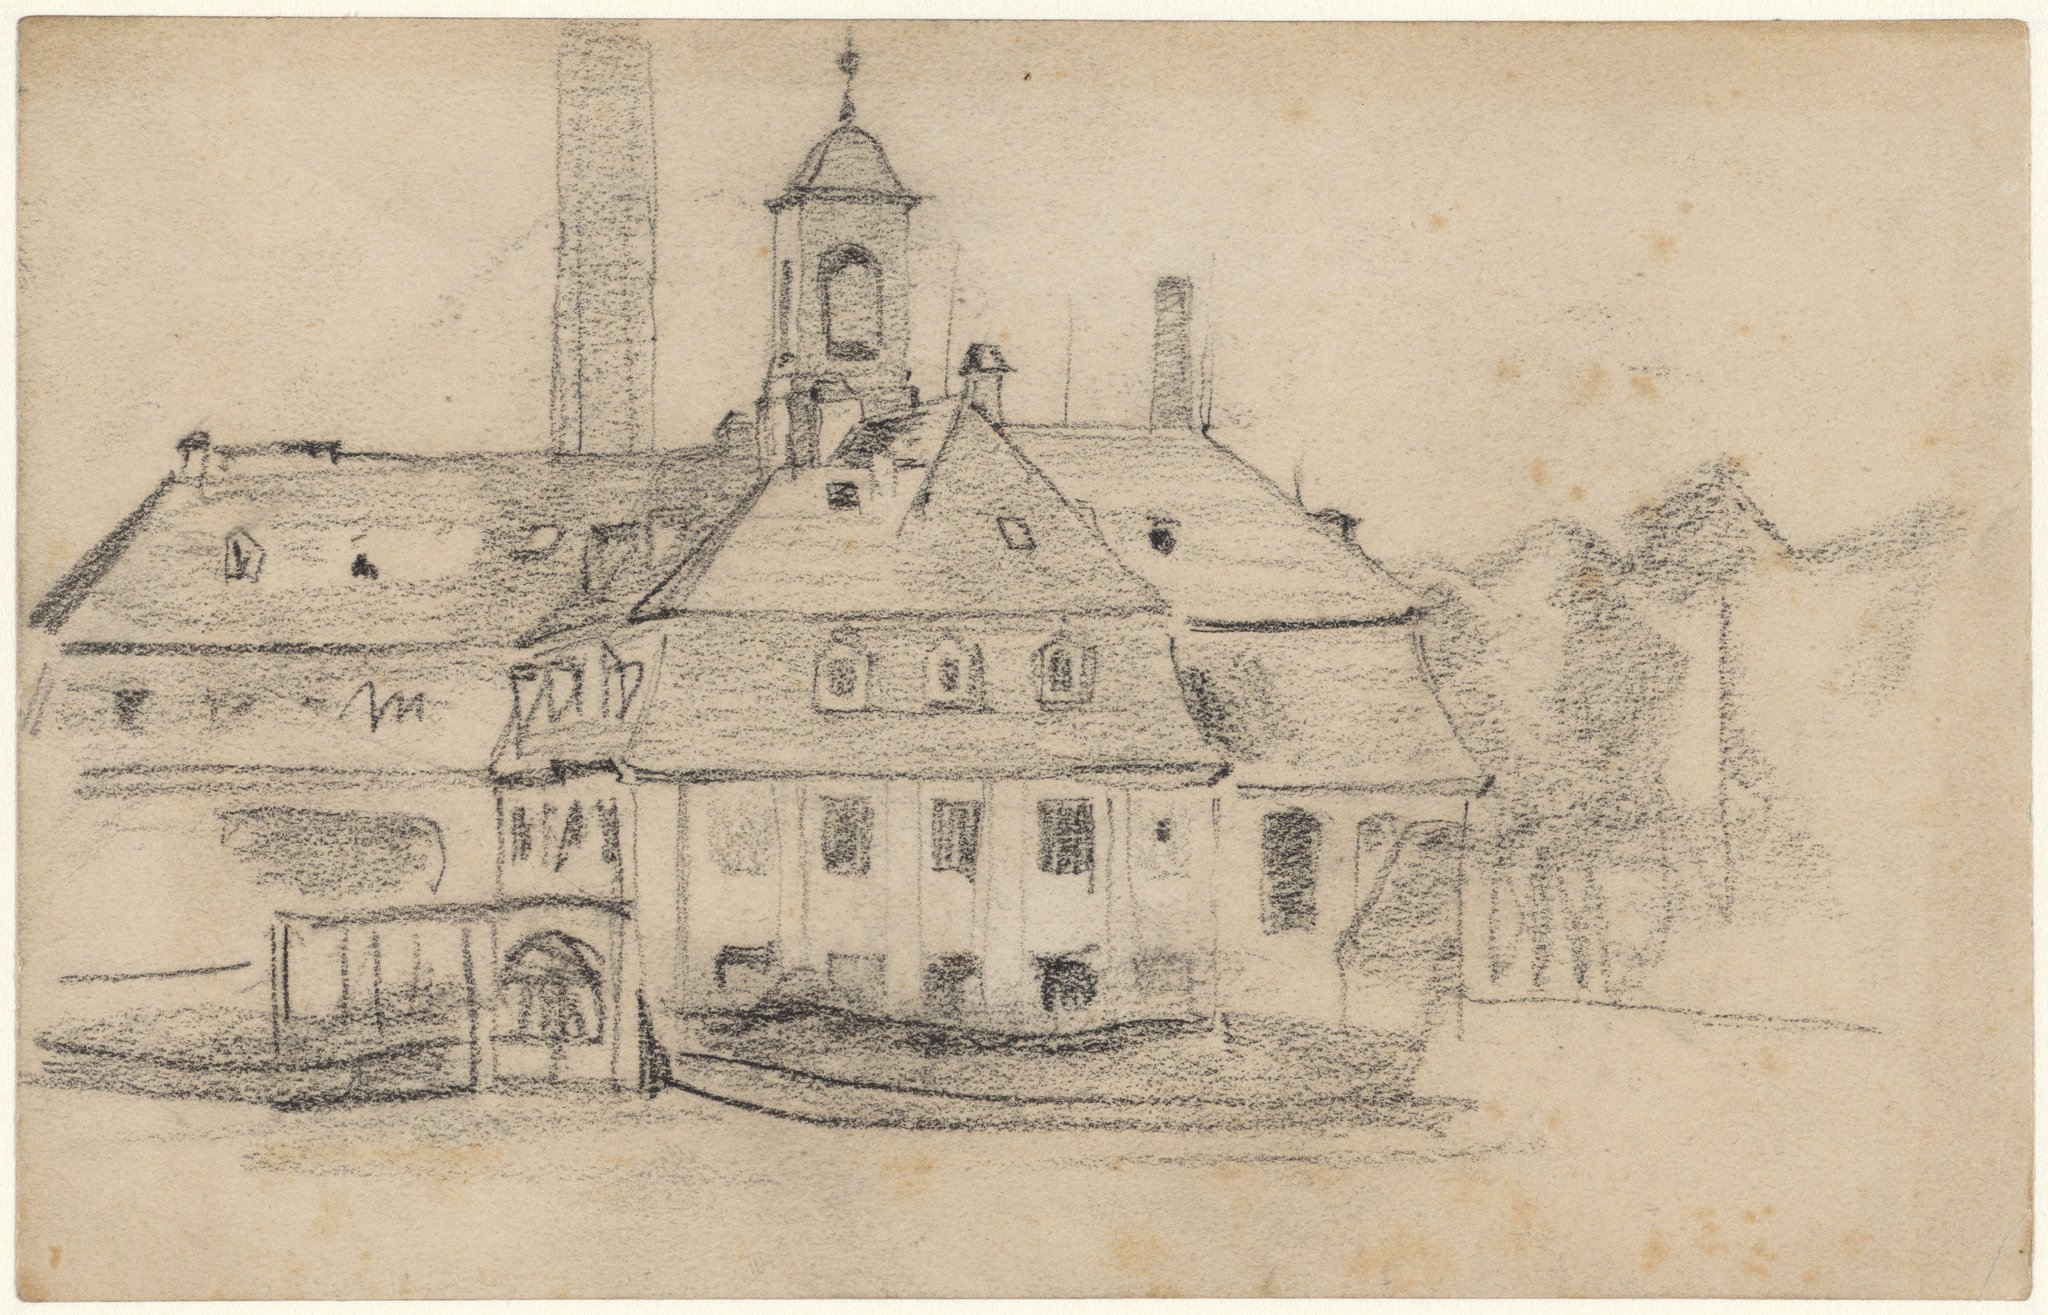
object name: drawing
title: Gebouwen te Löbtau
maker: theo nieuwenhuis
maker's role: designer, draughtsman, print maker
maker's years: 1866-1951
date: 1876-1951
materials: chalk, paper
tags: public road, germany